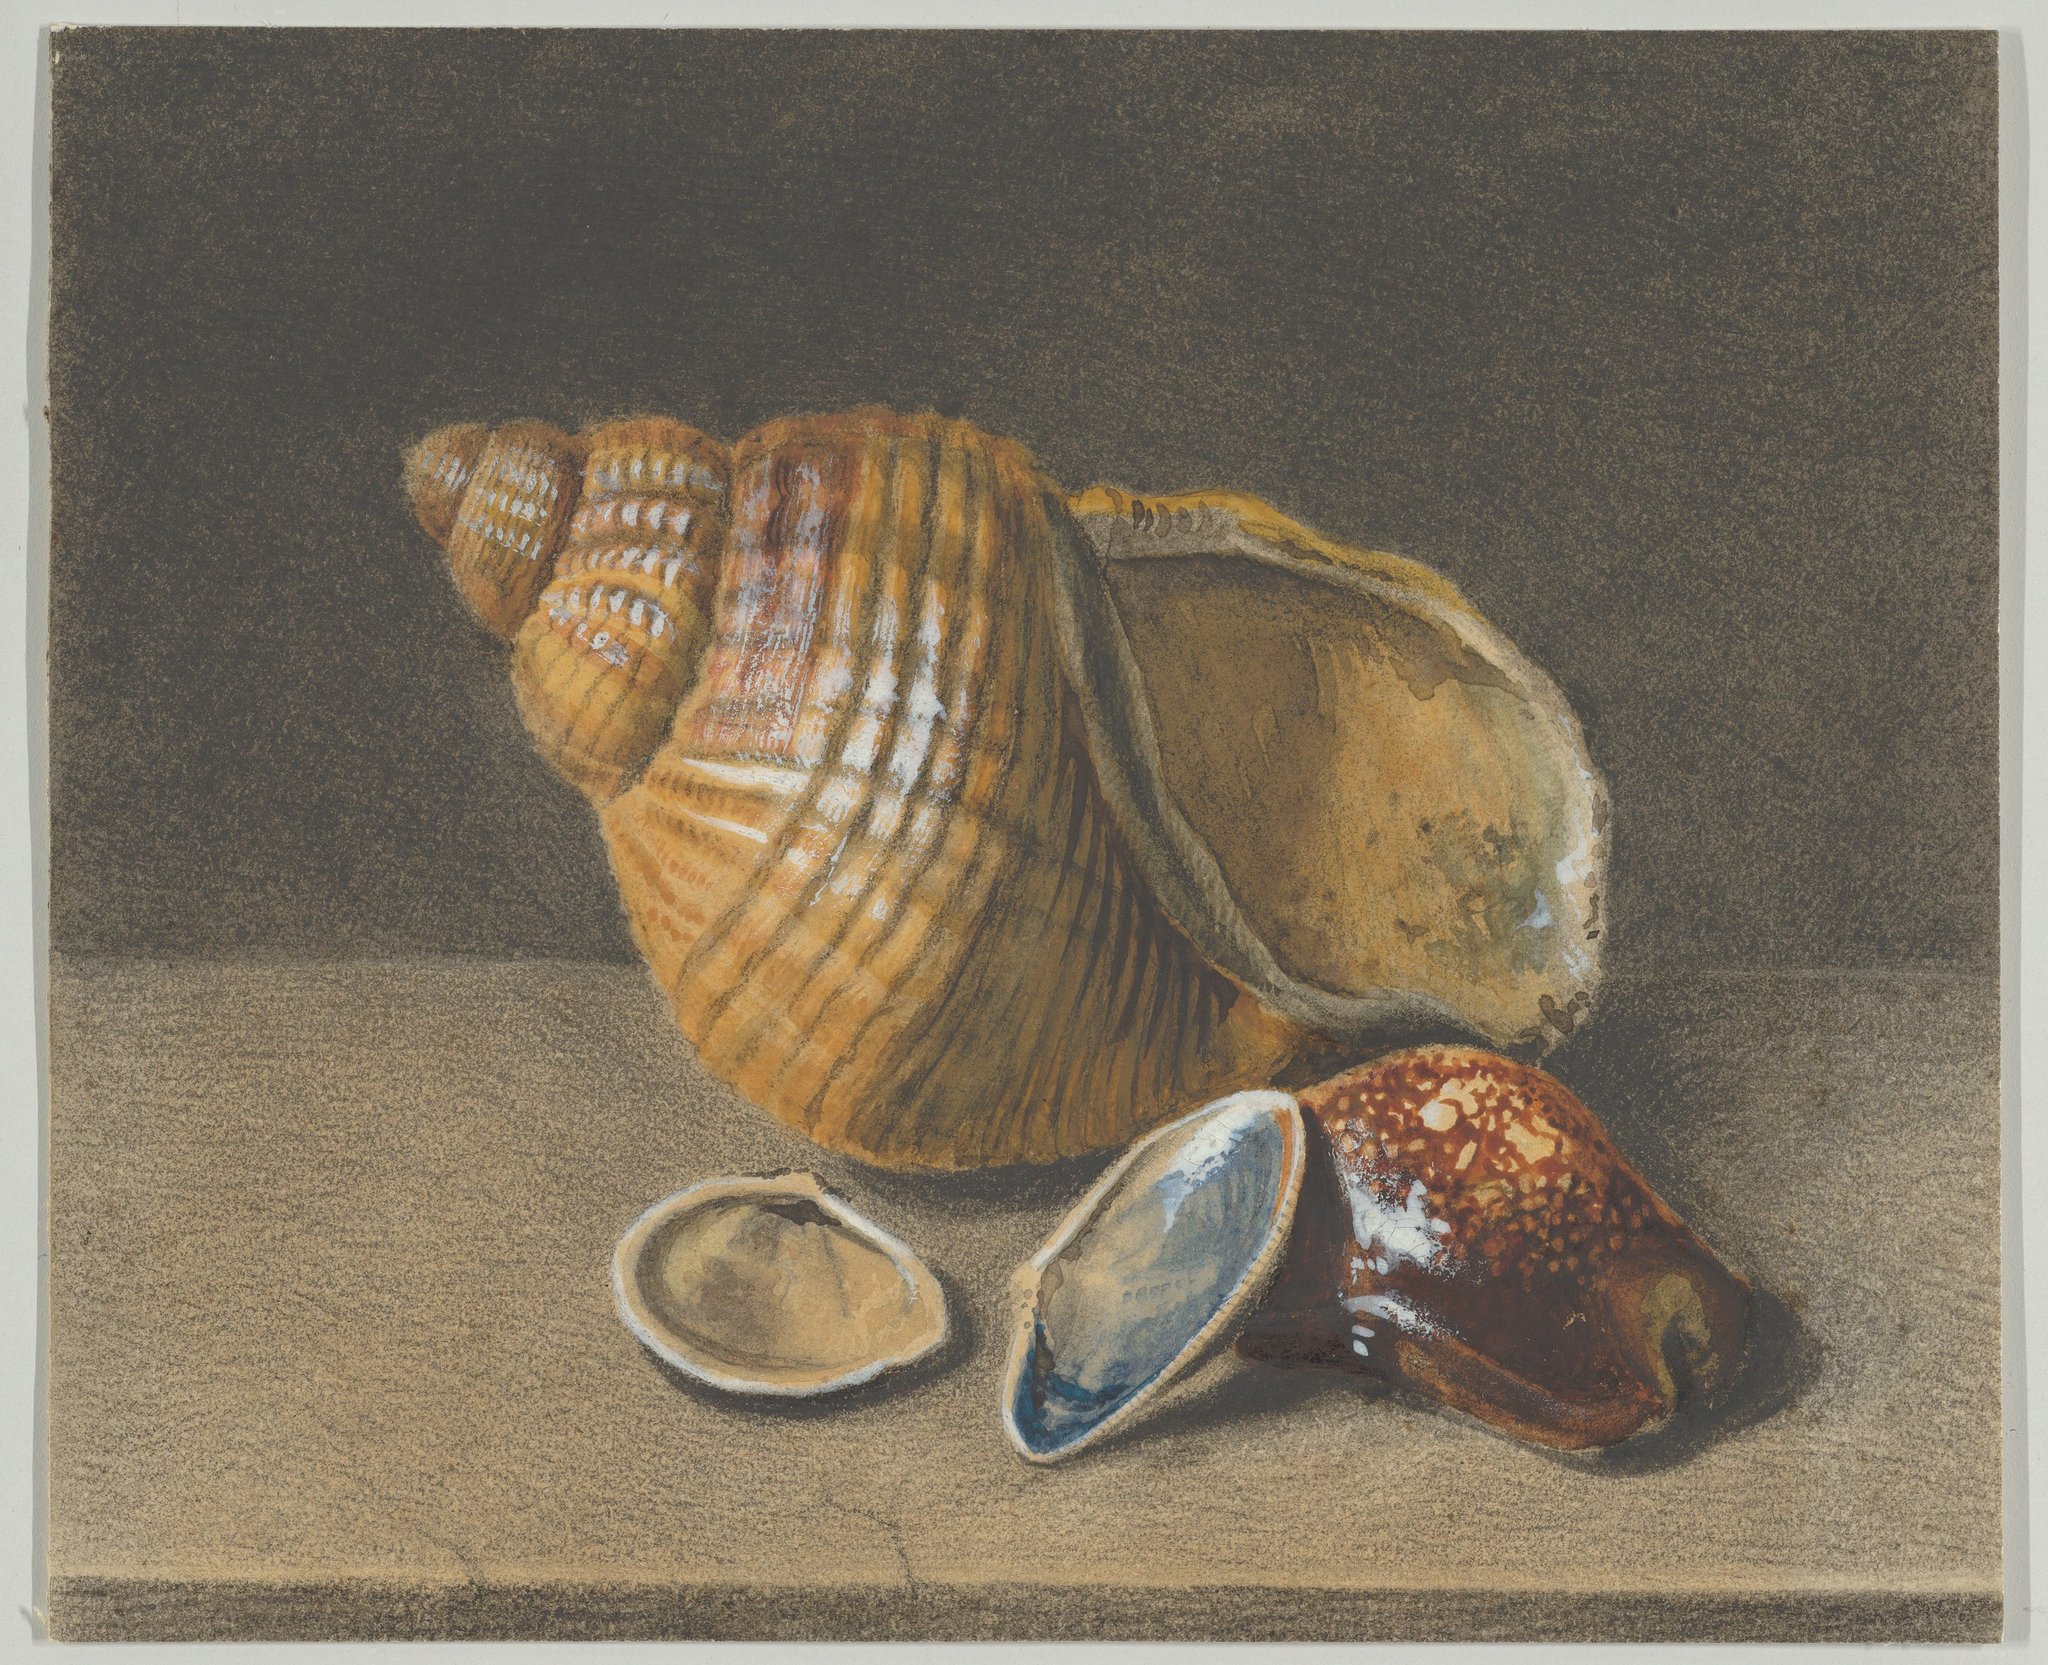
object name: drawing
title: A Cowrie, and a Larger and Two Smaller Shells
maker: Anonymous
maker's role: artist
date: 1667-1766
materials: gouache, graphite, watercolor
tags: shells